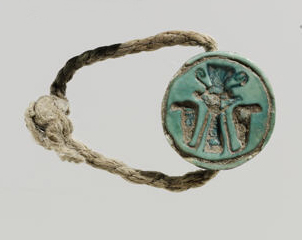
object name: ring, cowroid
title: Cowroid ring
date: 1479-1458 BCE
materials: linen, stone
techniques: glazing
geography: egypt